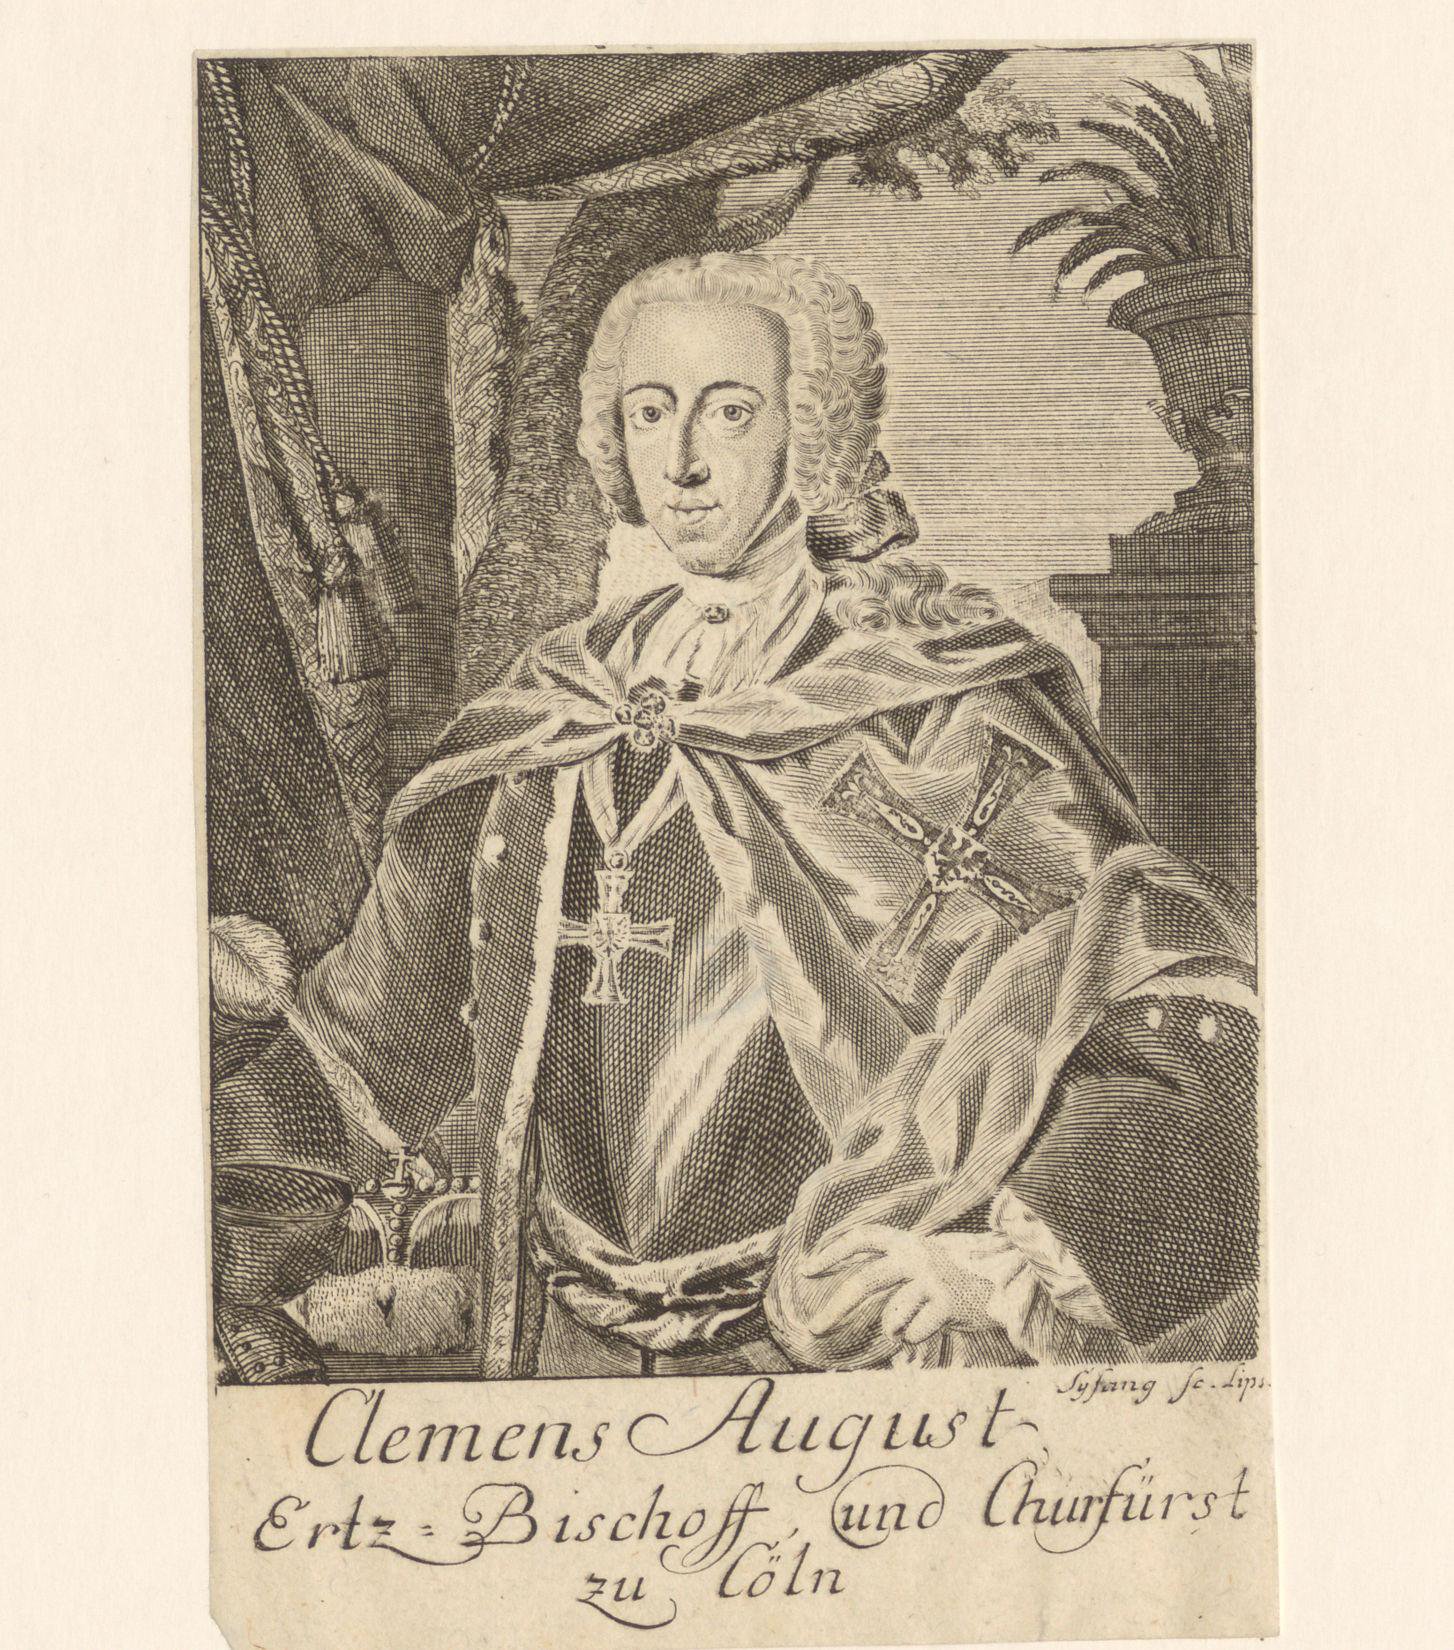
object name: print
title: Portret van Clemens August von Bayern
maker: johann christoph sysang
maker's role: print maker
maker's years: 1703-1757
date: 1723-1757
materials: paper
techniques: engraving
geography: leipzig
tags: brussels, helmet, crown (symbol of sovereignty), historical persons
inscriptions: collector's mark: Lugt 2228